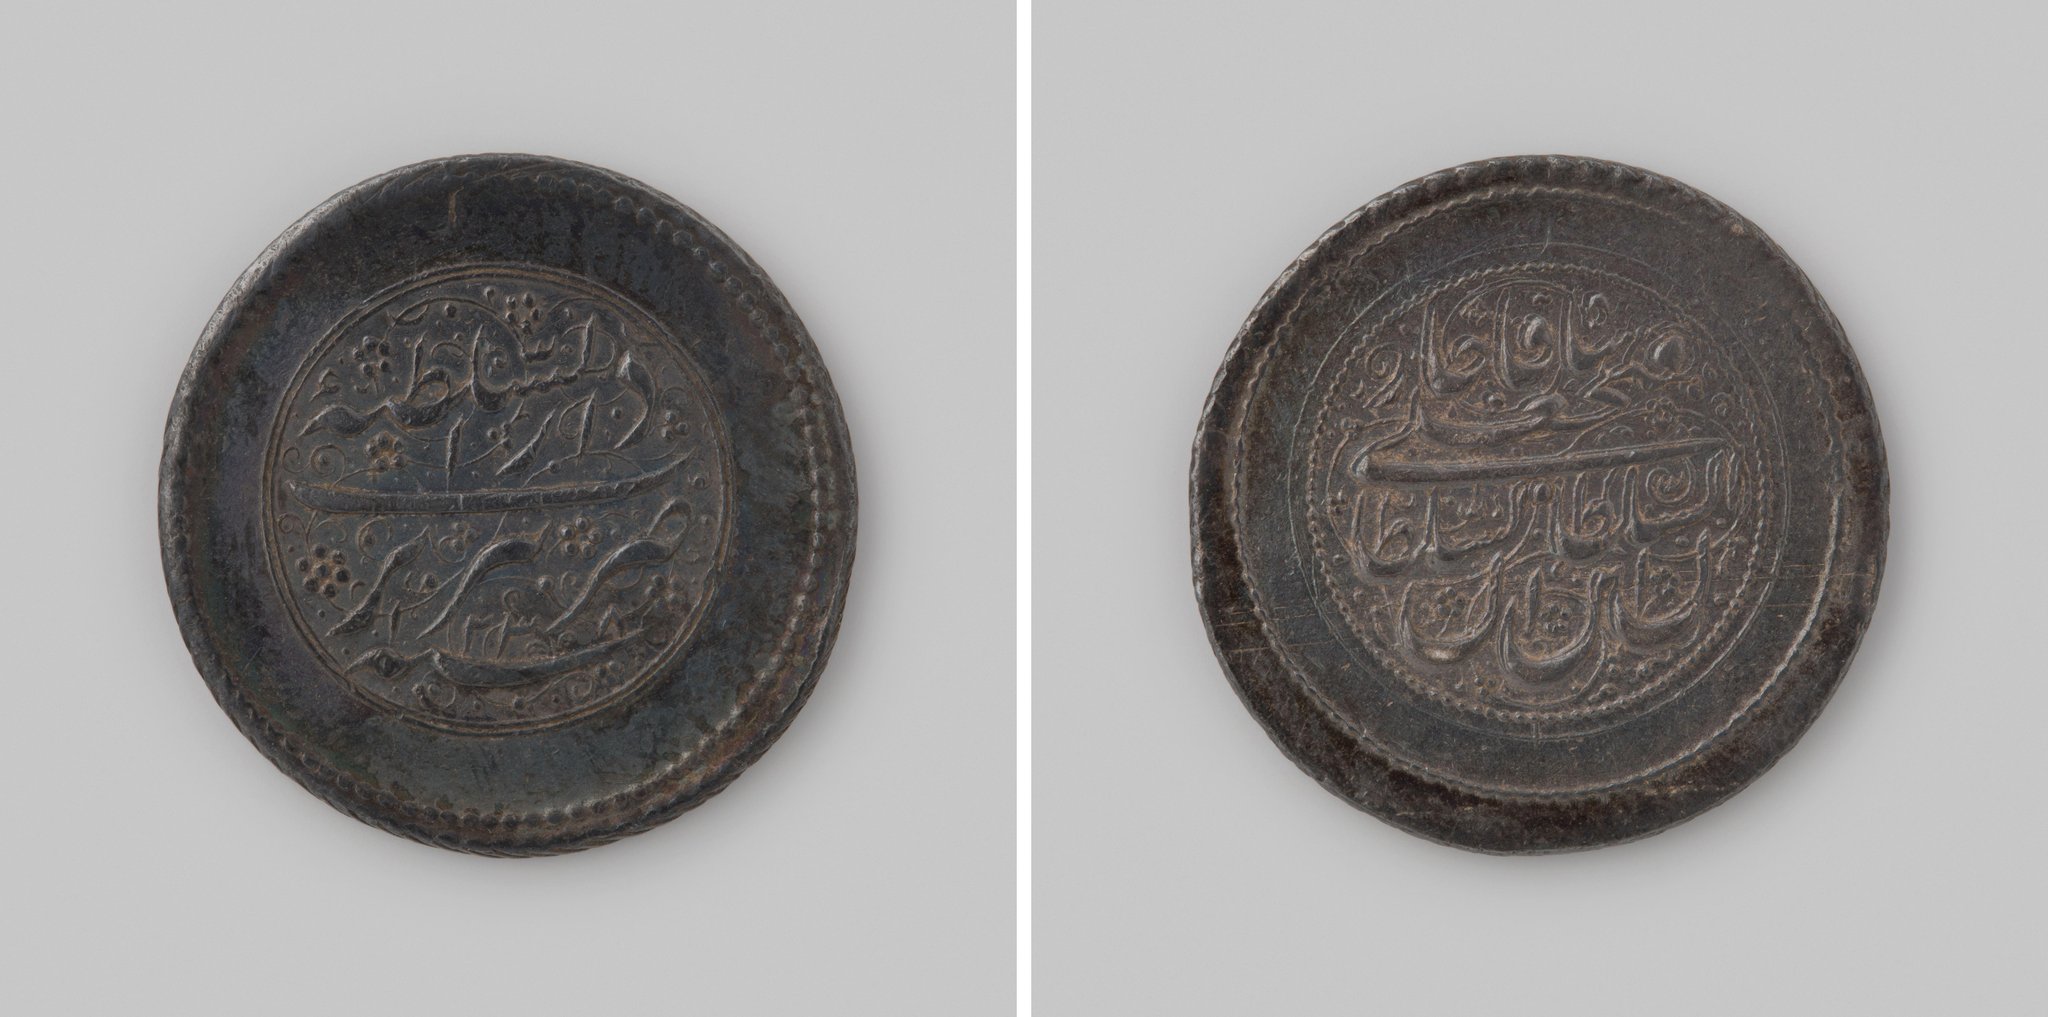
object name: coin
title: Perzië, Fateh Ali Shah, 1212-1250 AH [=1798-1835], ryal,1238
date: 1823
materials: silver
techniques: striking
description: Zilveren munt. Voorzijde: binnen cirkel in Arabische lettertekens opschrift in vier regels: naam van de shah.Rondom cirkel brede, gladde rand. Keerzijde: binnen cirkel in Arabische lettertekens in vier regels onder meer muntplaats-aanduiding: Tabriz. Daartussen jaartal: 1238. Rondom cirkel brede, gladde rand. Kabelrand.